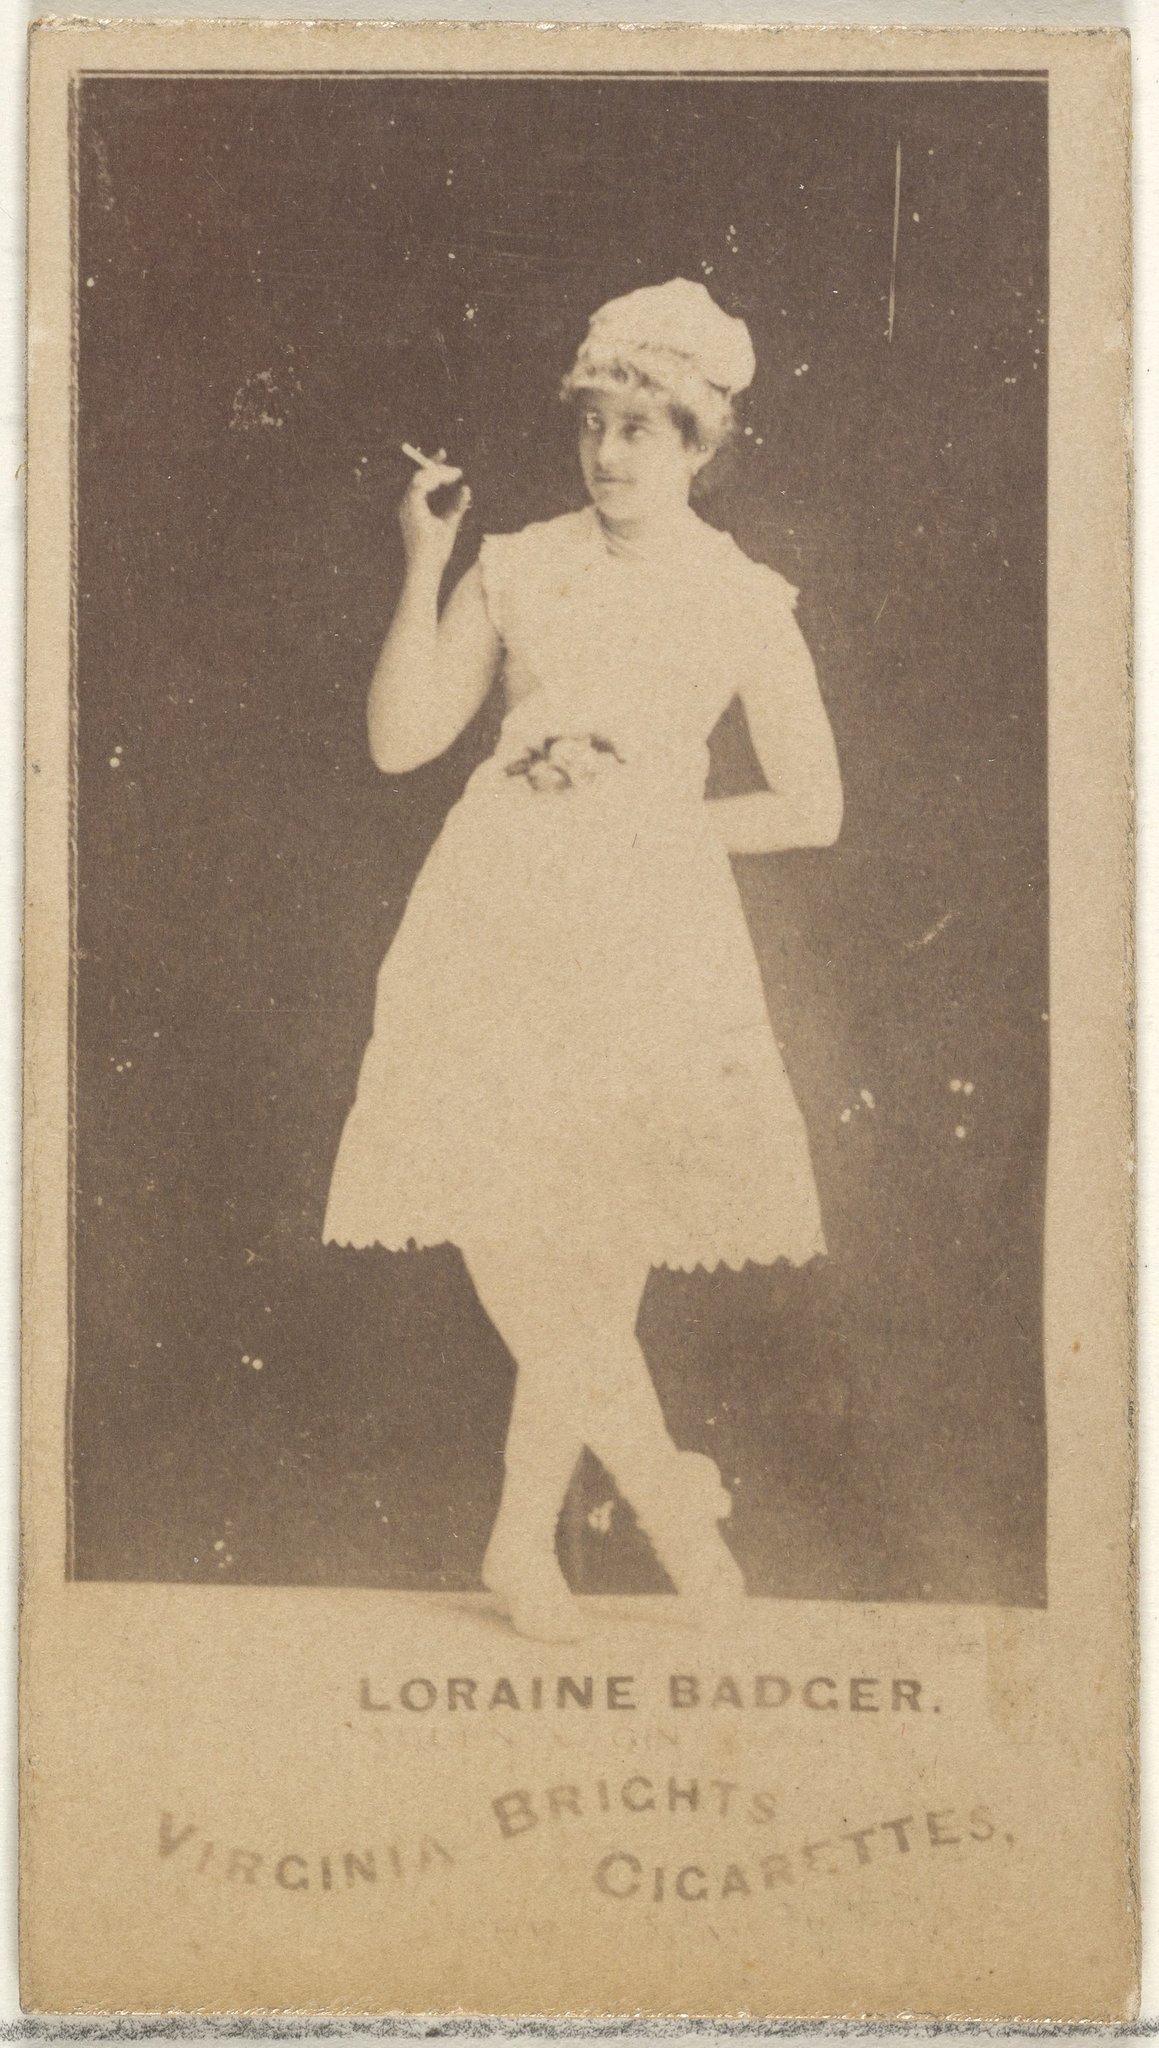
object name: photograph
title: Loraine Badger, from the Actors and Actresses series (N45, Type 1) for Virginia Brights Cigarettes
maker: allen & ginter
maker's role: publisher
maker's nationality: american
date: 1888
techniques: albumen silver print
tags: portraits,women,smoking,actresses